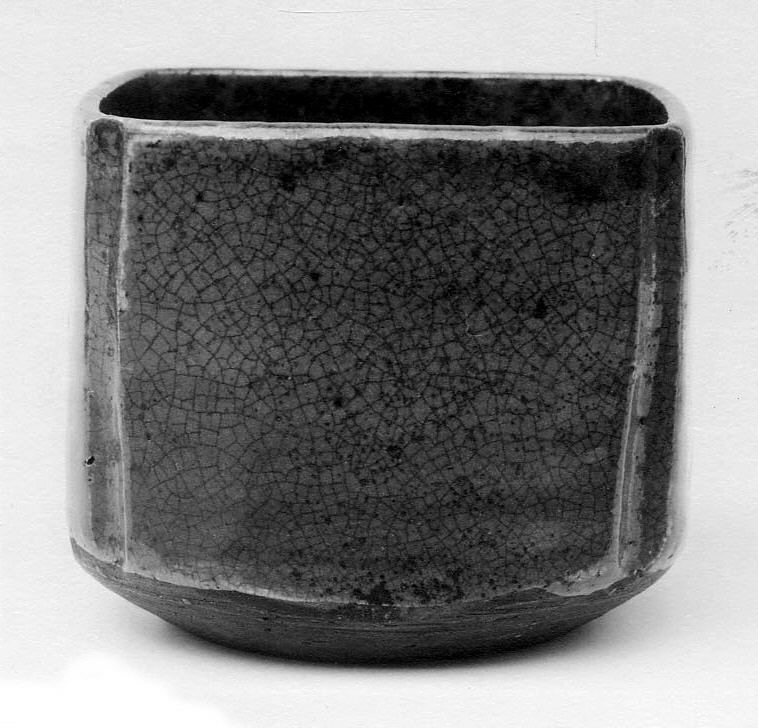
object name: teabowl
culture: japanese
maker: hachiroemon murase ii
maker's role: artist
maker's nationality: japanese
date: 1865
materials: clay, glaze